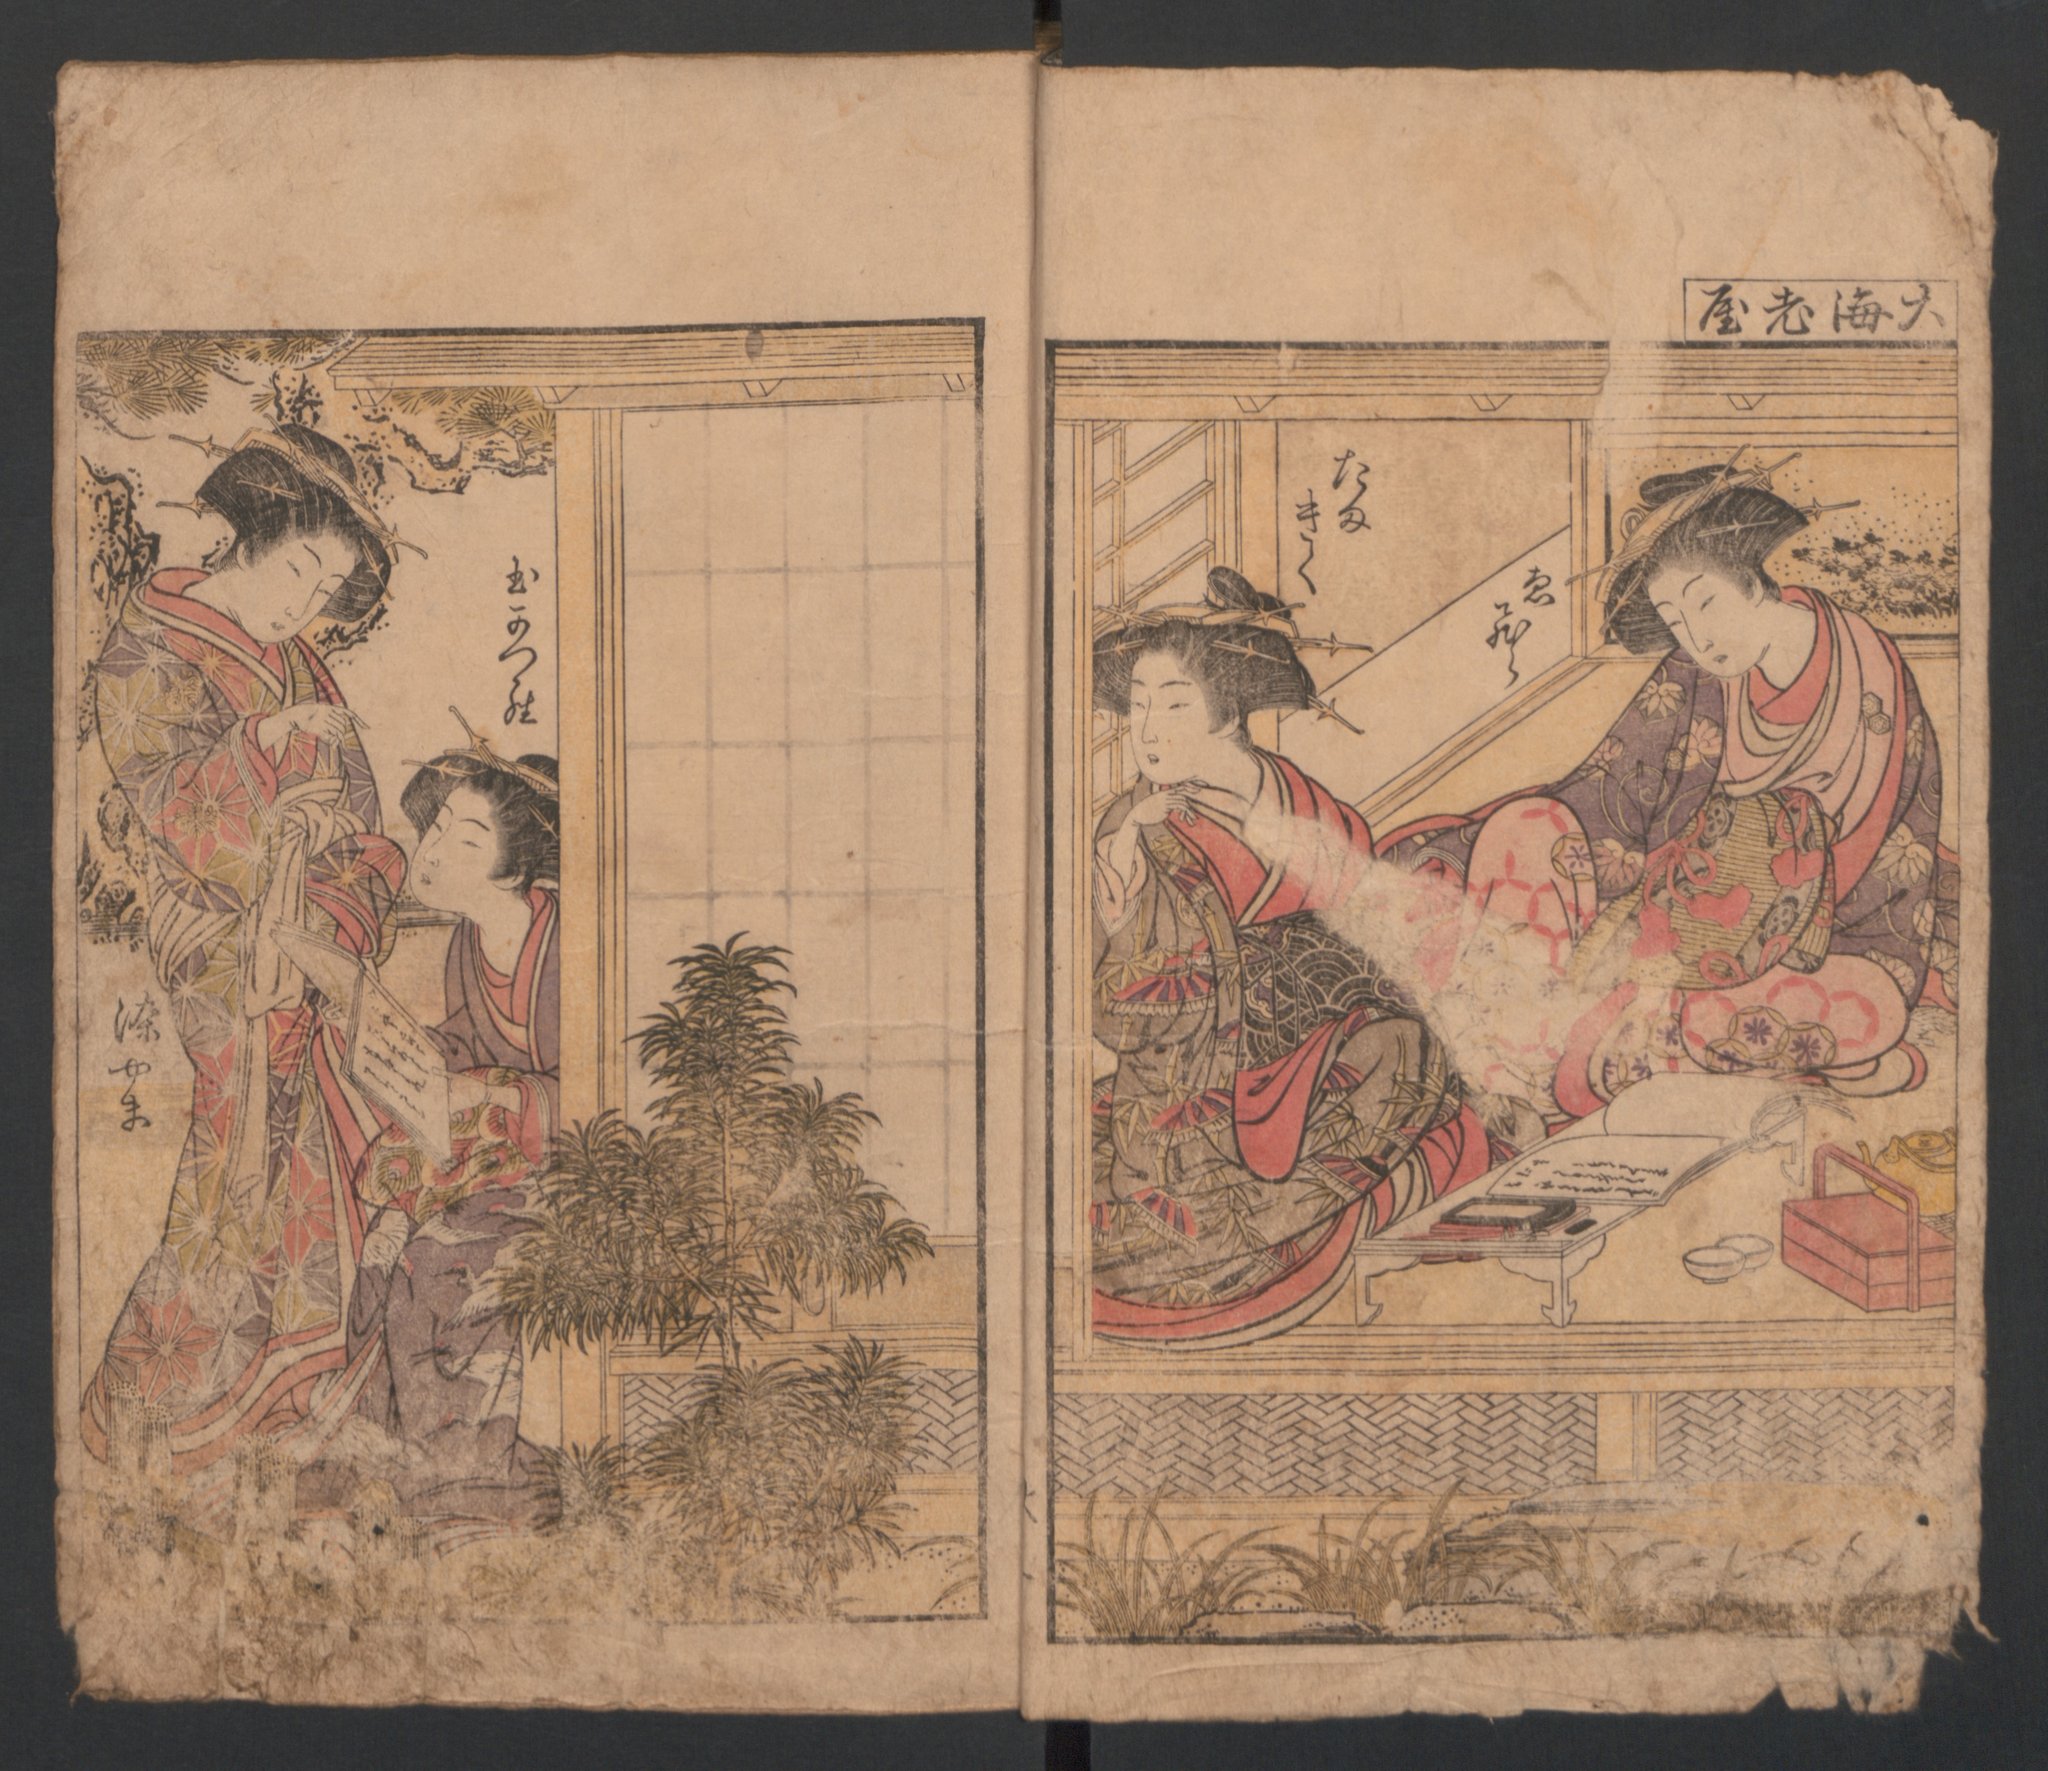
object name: illustrated book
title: Mirror of the Beautiful Women of the Yoshiwara Brothels (Seirō bijin awase sugata kagami) 青楼美人合姿鏡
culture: japanese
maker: katsukawa shunshō 勝川春章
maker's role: artist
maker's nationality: japanese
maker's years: 1726-1792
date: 1776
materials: ink, paper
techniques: polychrome, woodblock print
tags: women,reading,plants